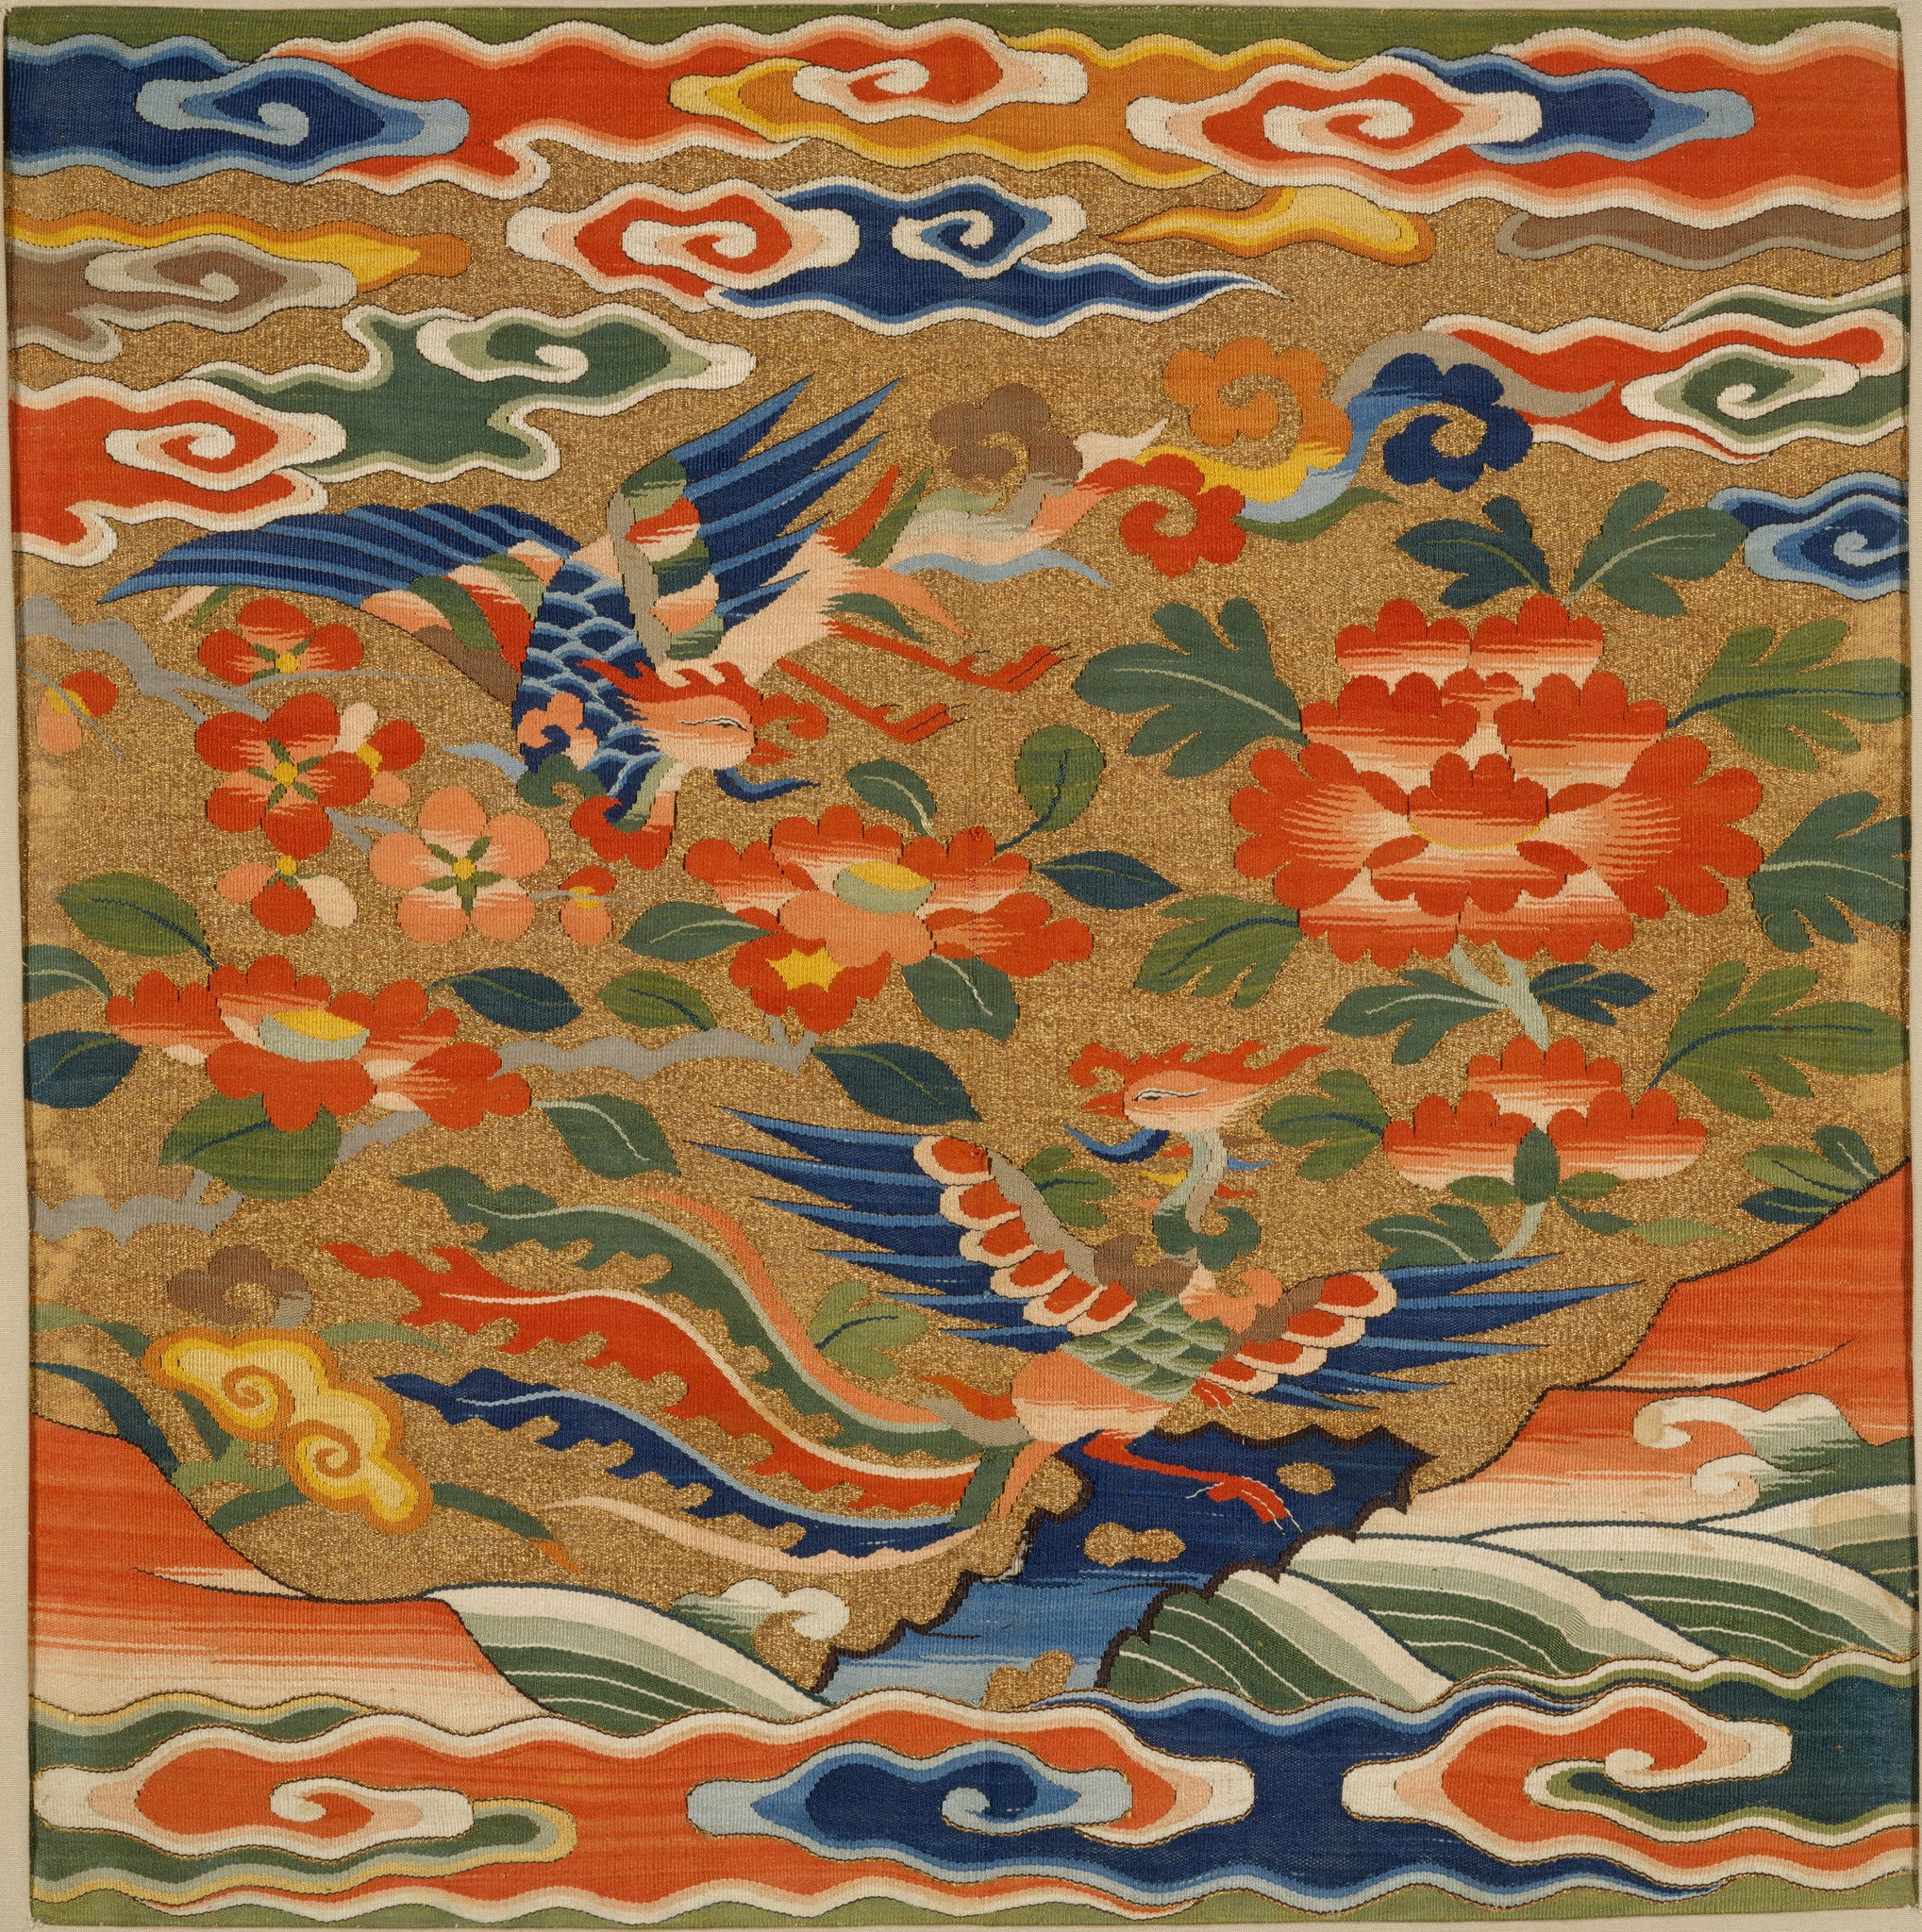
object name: rank badge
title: Rank badge with two phoenixes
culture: chinese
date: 1501-1600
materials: metal thread, silk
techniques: tapestry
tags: phoenix